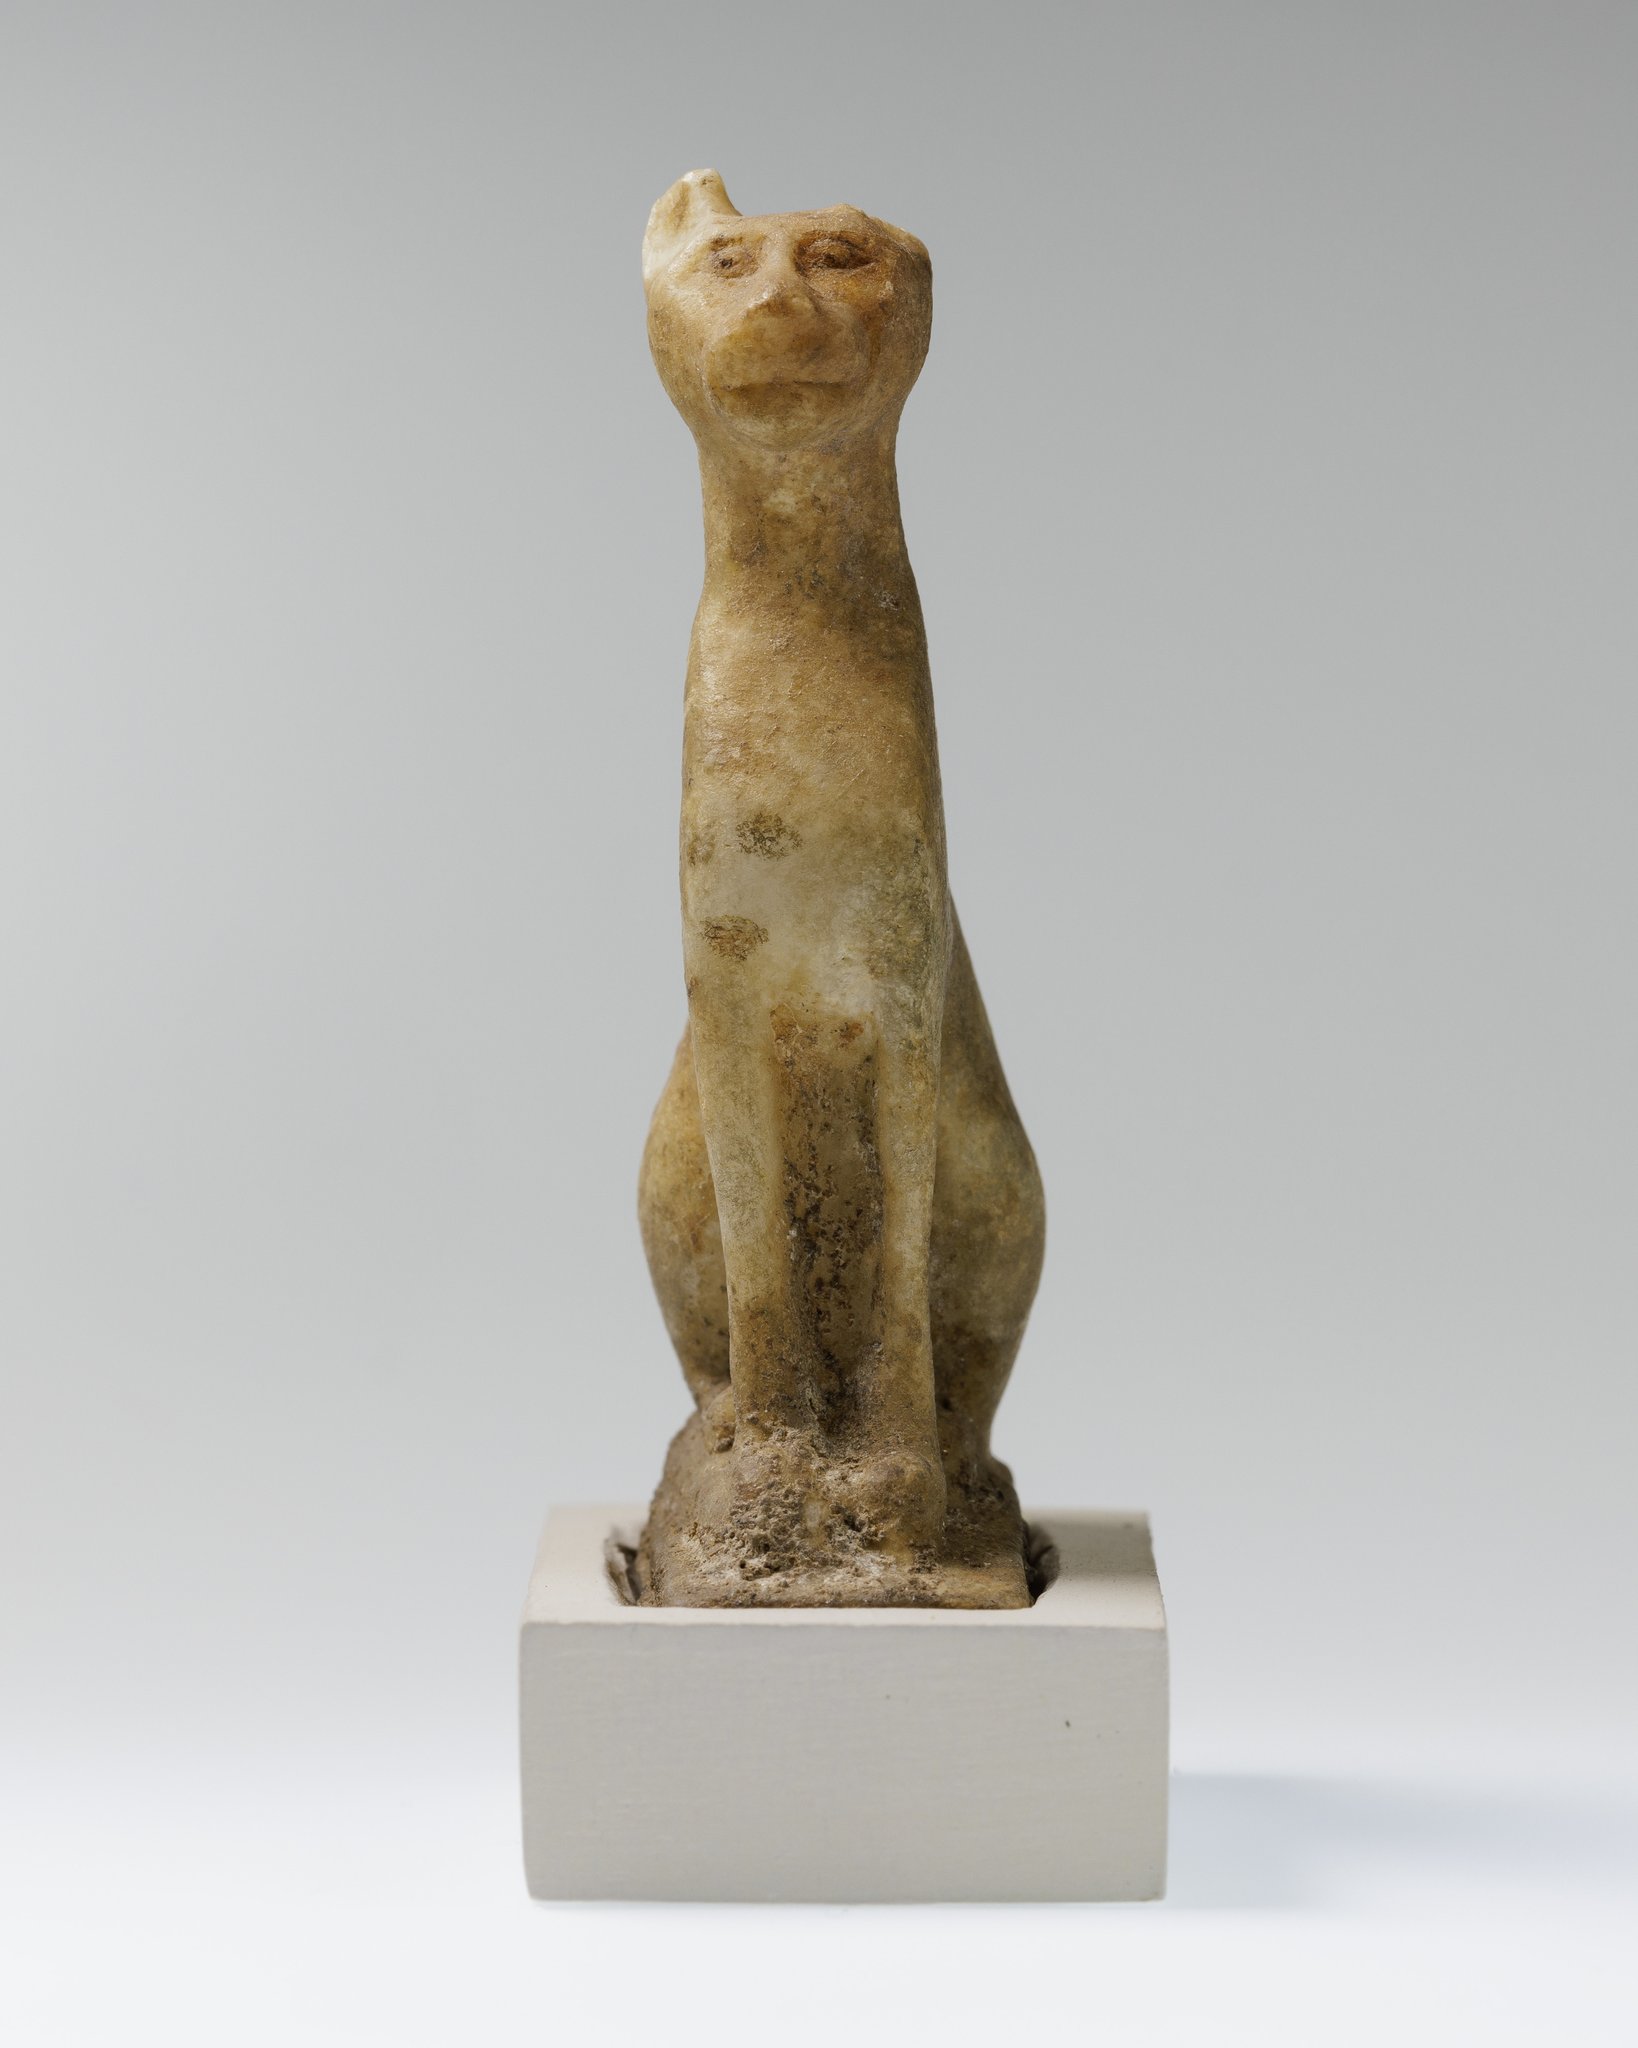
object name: statuette, cat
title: Statuette of cat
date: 664-332 BCE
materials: marble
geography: egypt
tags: cats